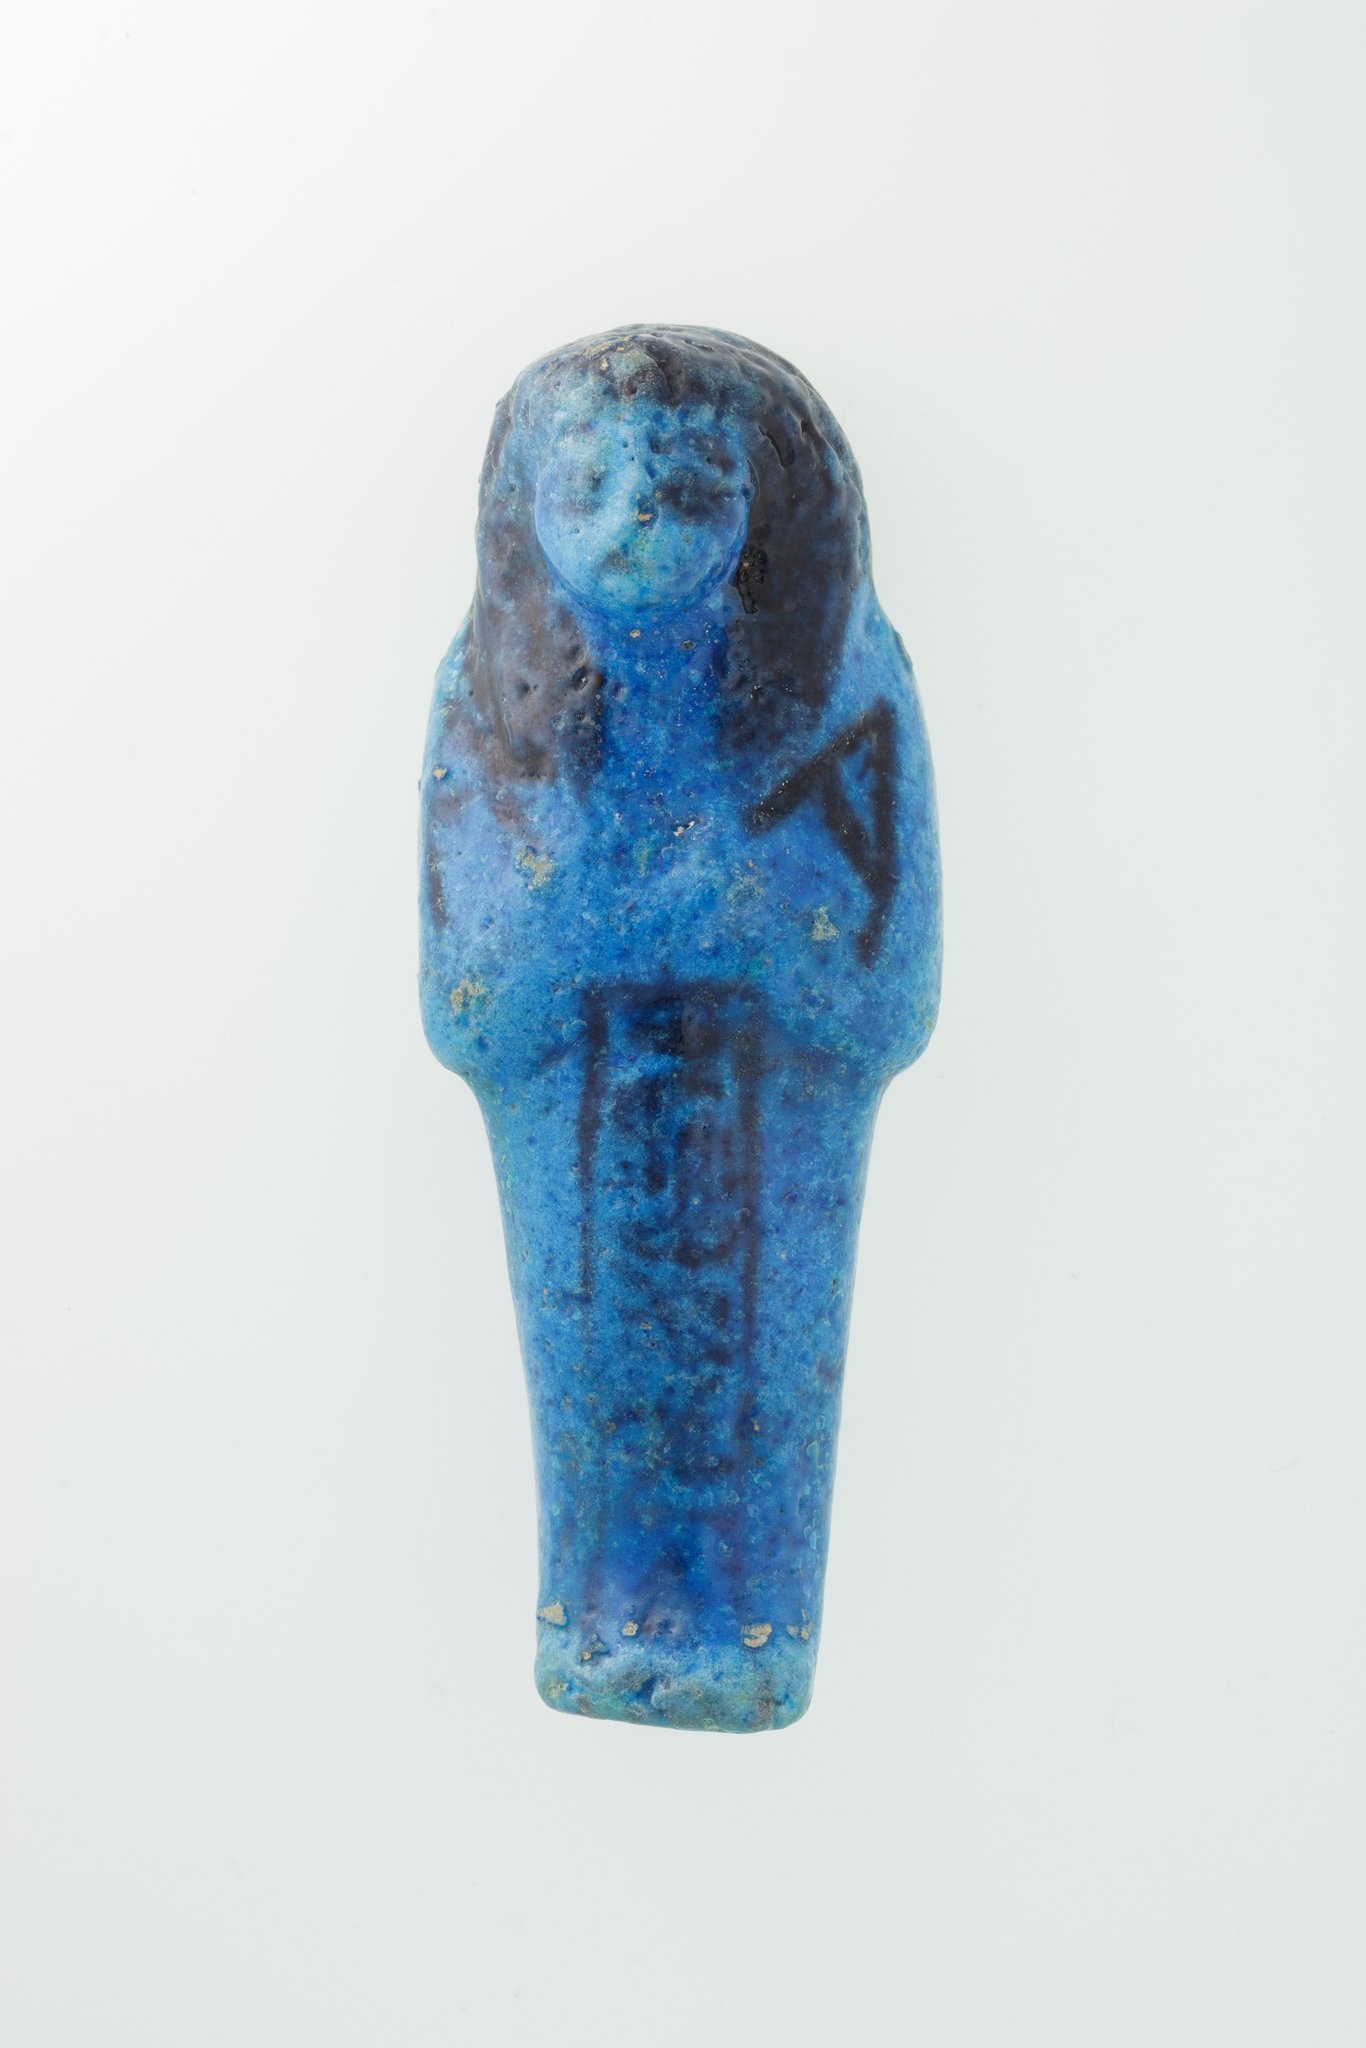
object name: shabti, worker, nauny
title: Worker Shabti of Nauny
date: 1050 BCE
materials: faience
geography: egypt